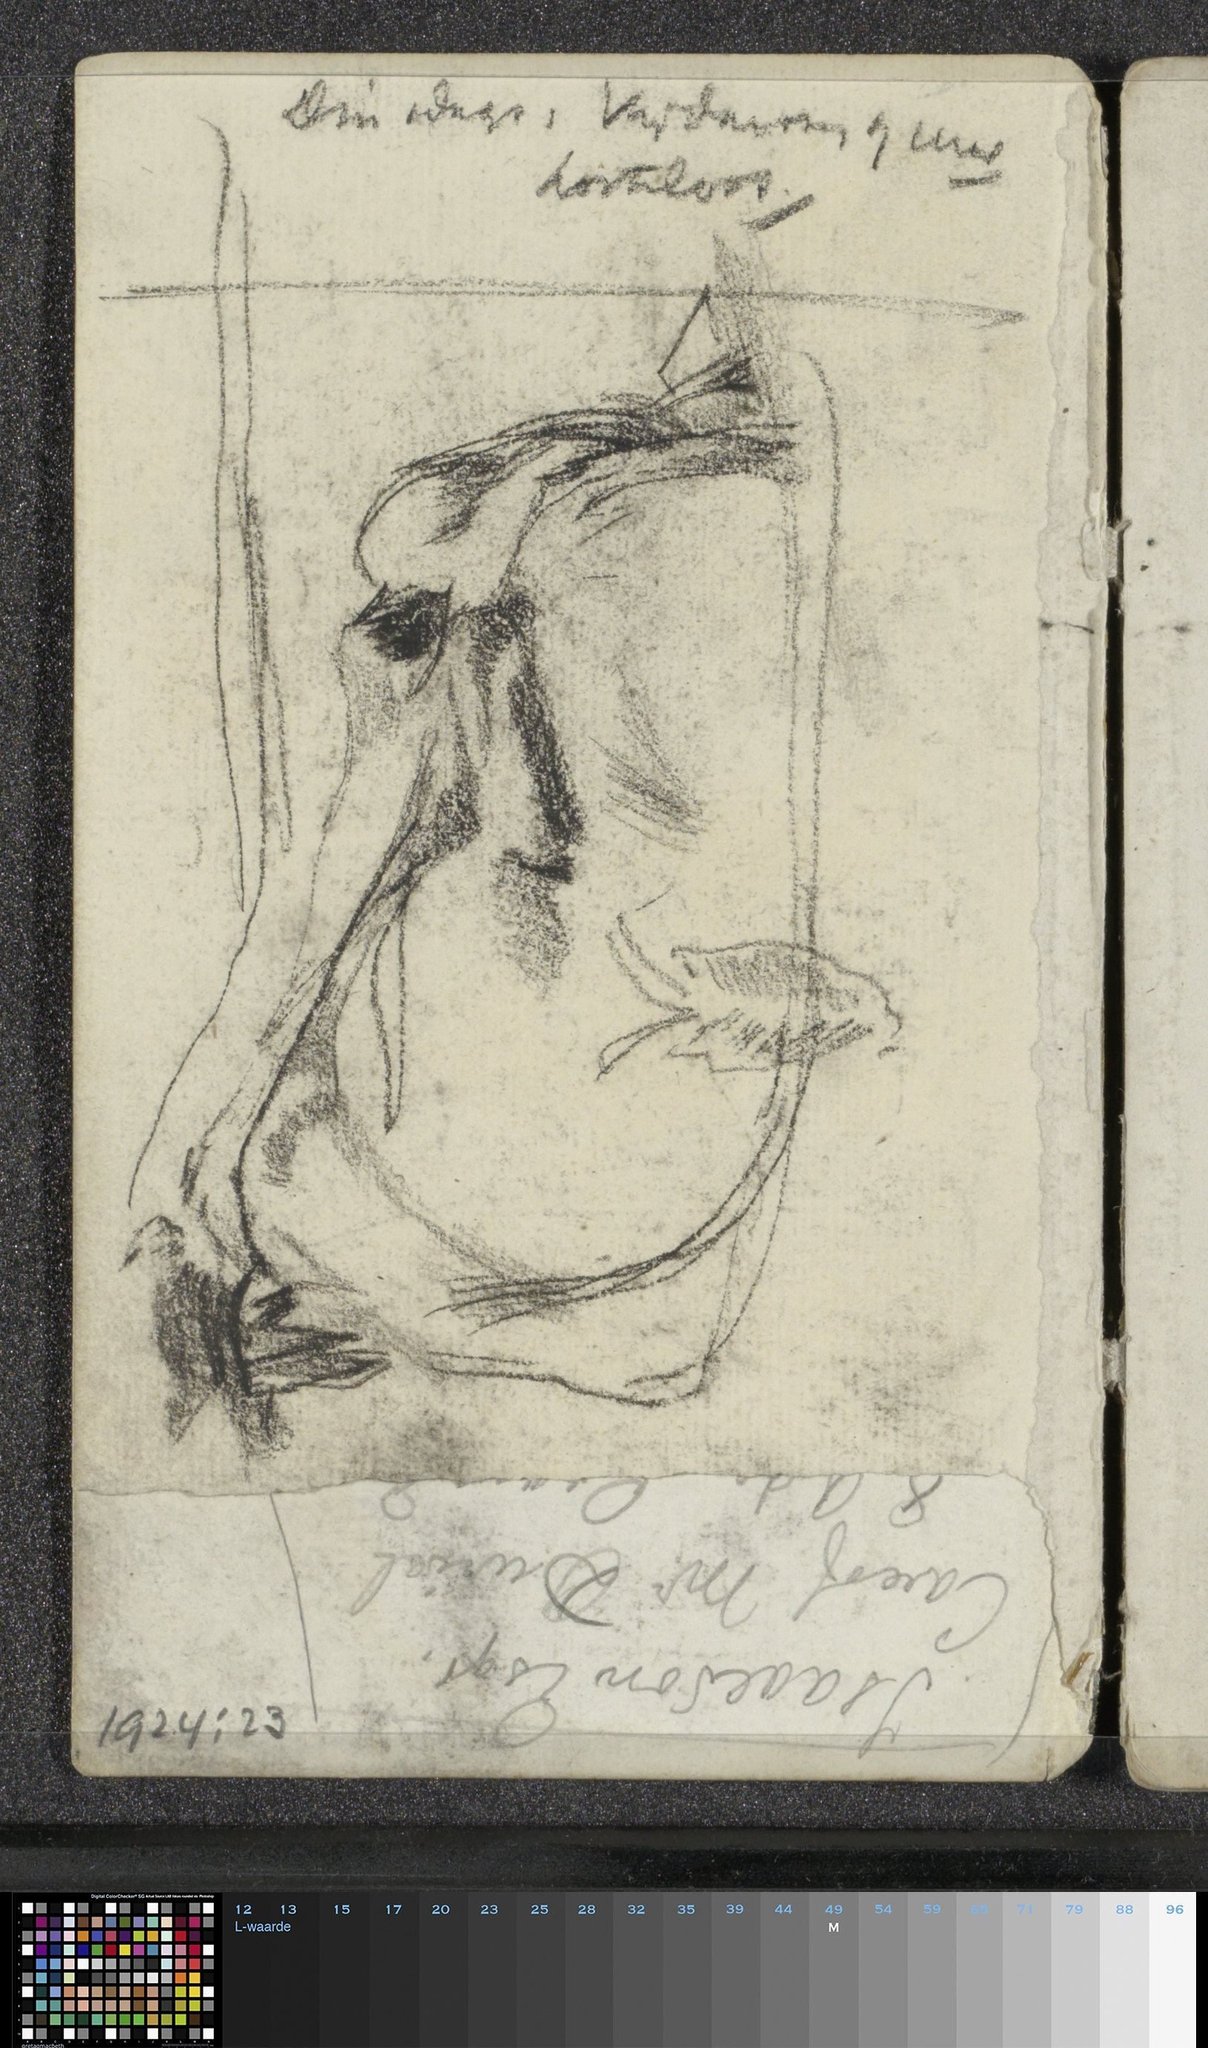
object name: sketchbook leaf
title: Twee liggende koeien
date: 1887-1889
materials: chalk, paper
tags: cow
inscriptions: annotation: ‘Dinsdags, [...]’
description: Pagina 3 uit een schetsboek met 27 bladen.